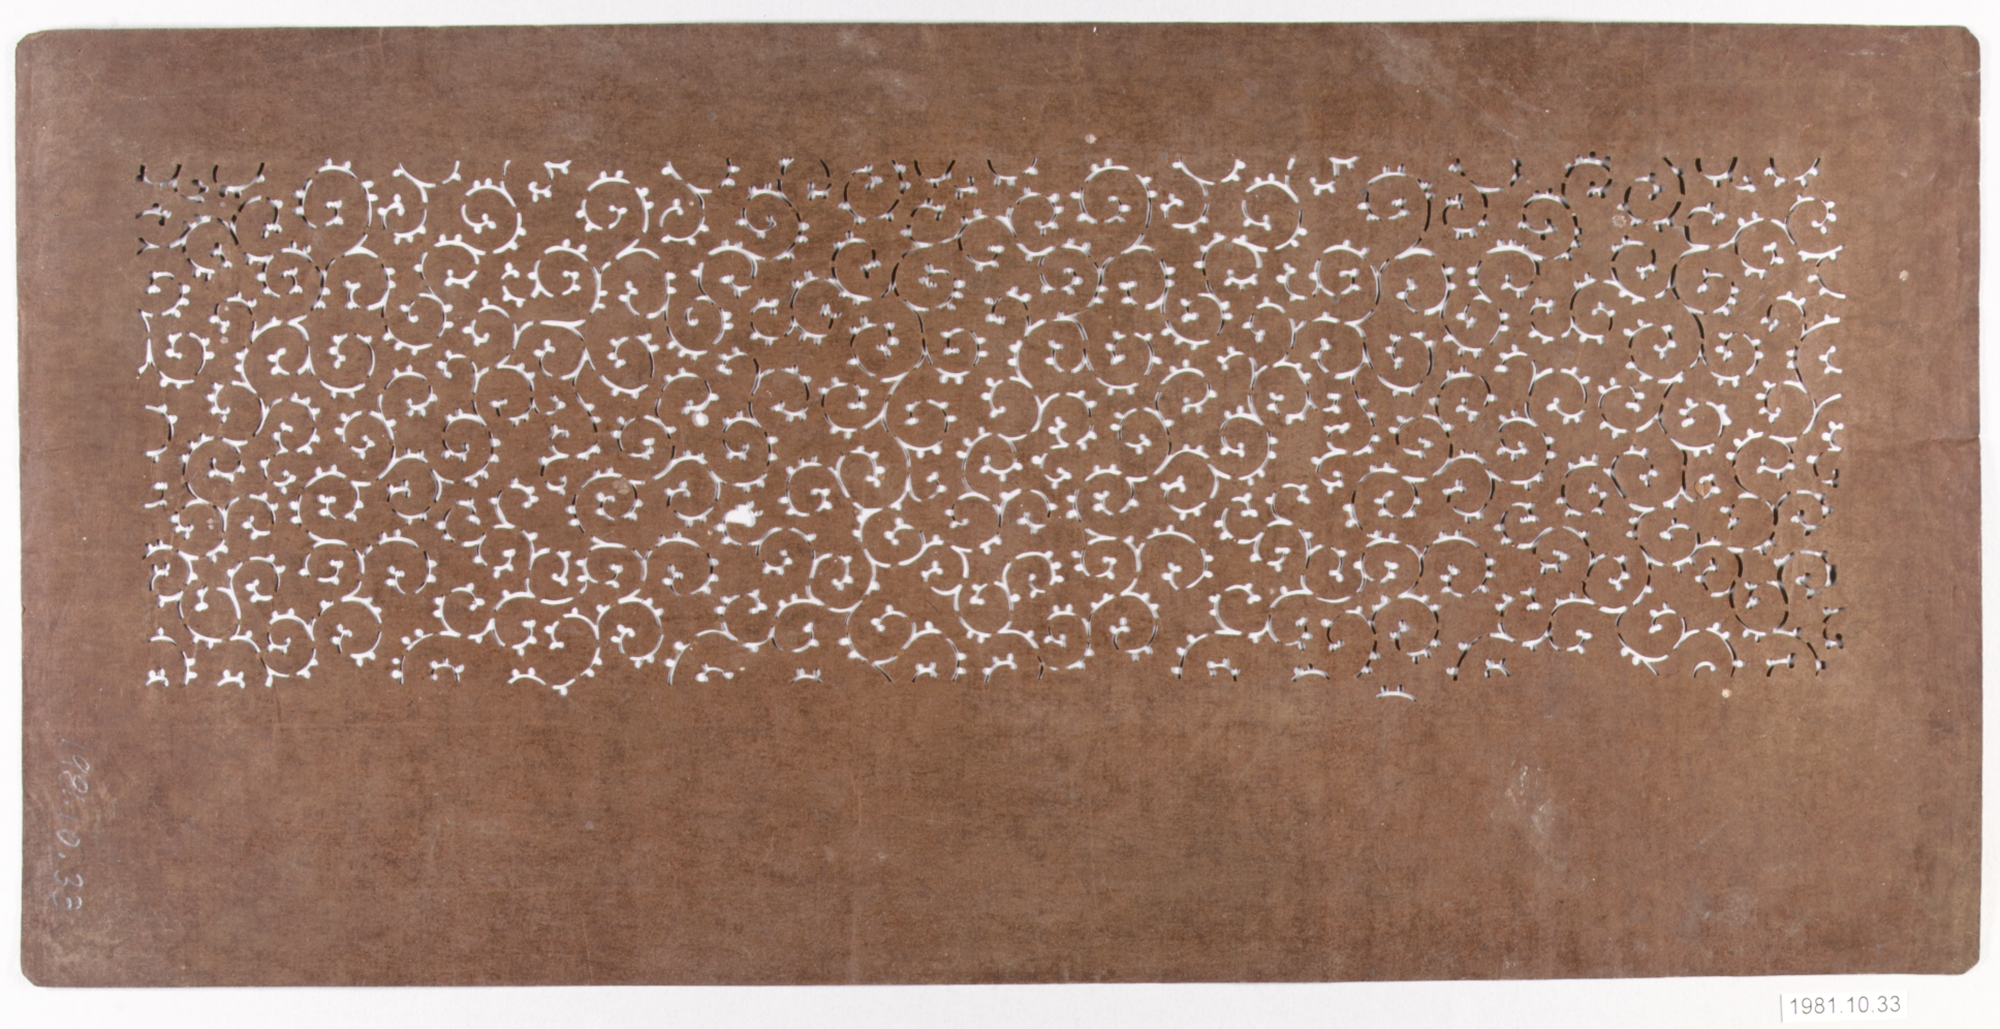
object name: stencil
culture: japanese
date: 1801-1900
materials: paper